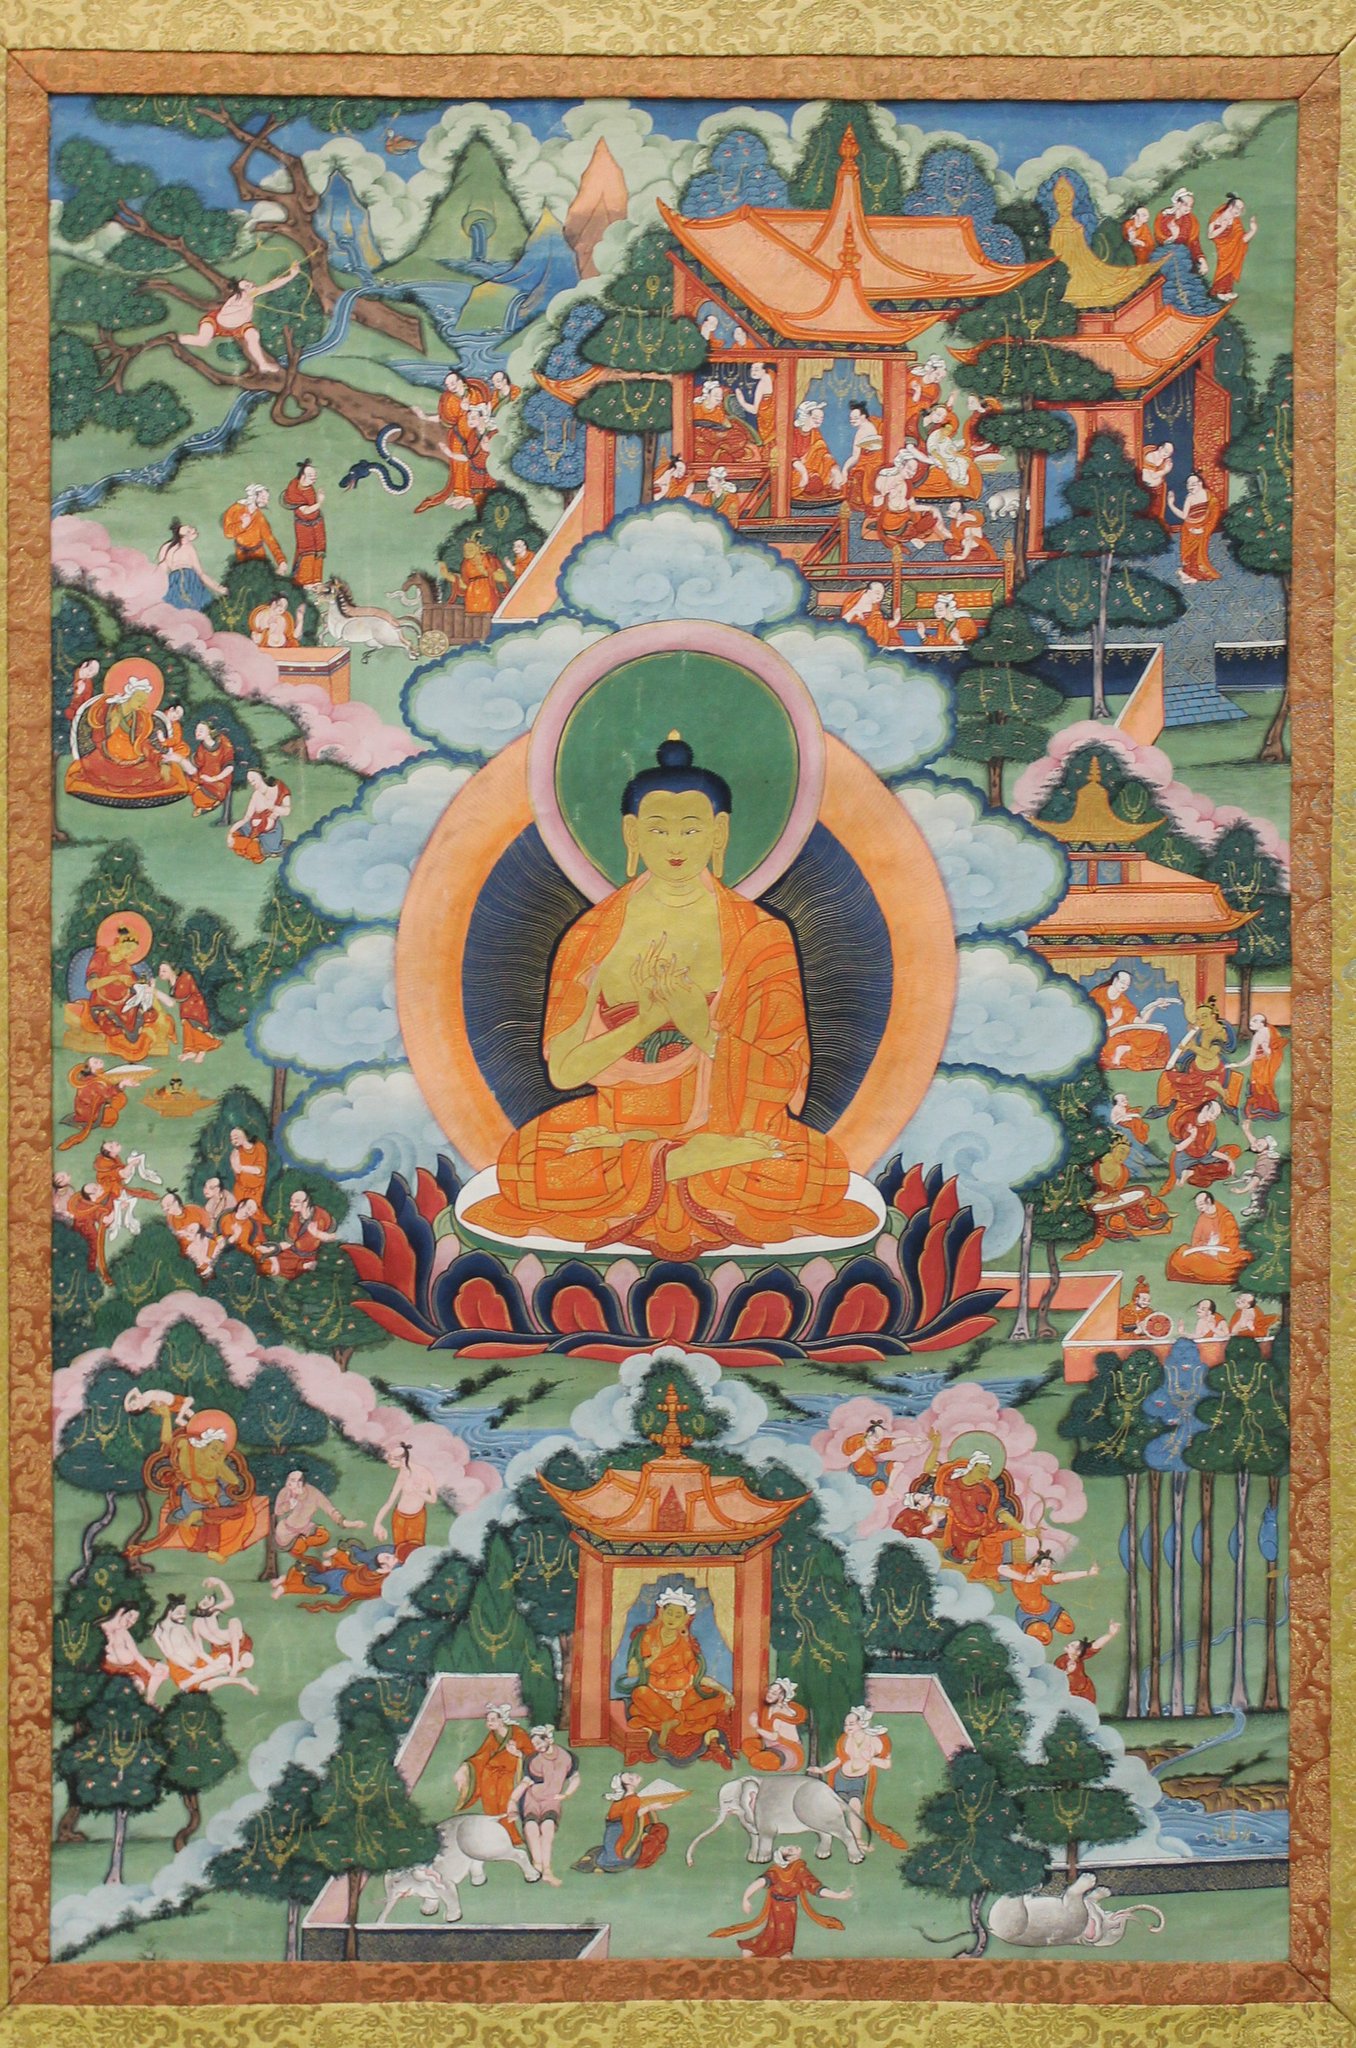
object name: thangka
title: Thangka with Buddha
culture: tibetan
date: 1801-1900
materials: textile